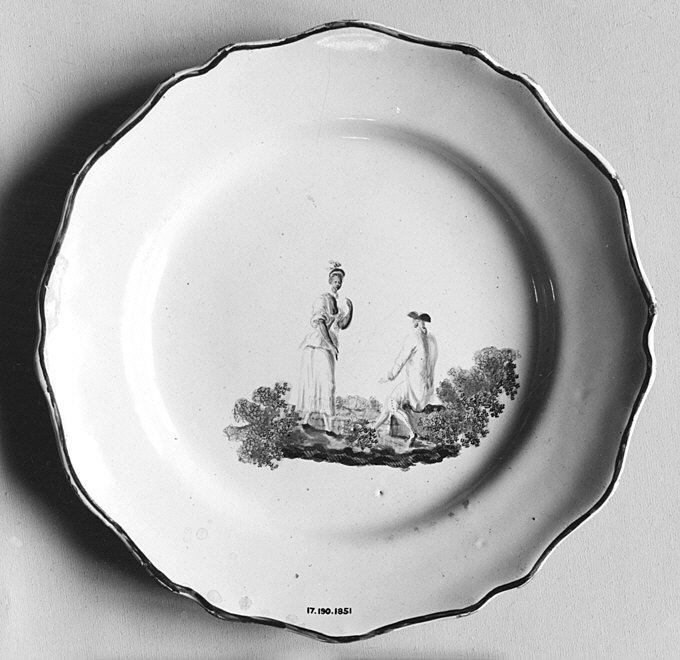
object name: plate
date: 1785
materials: faience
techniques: glazing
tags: men,women,plants